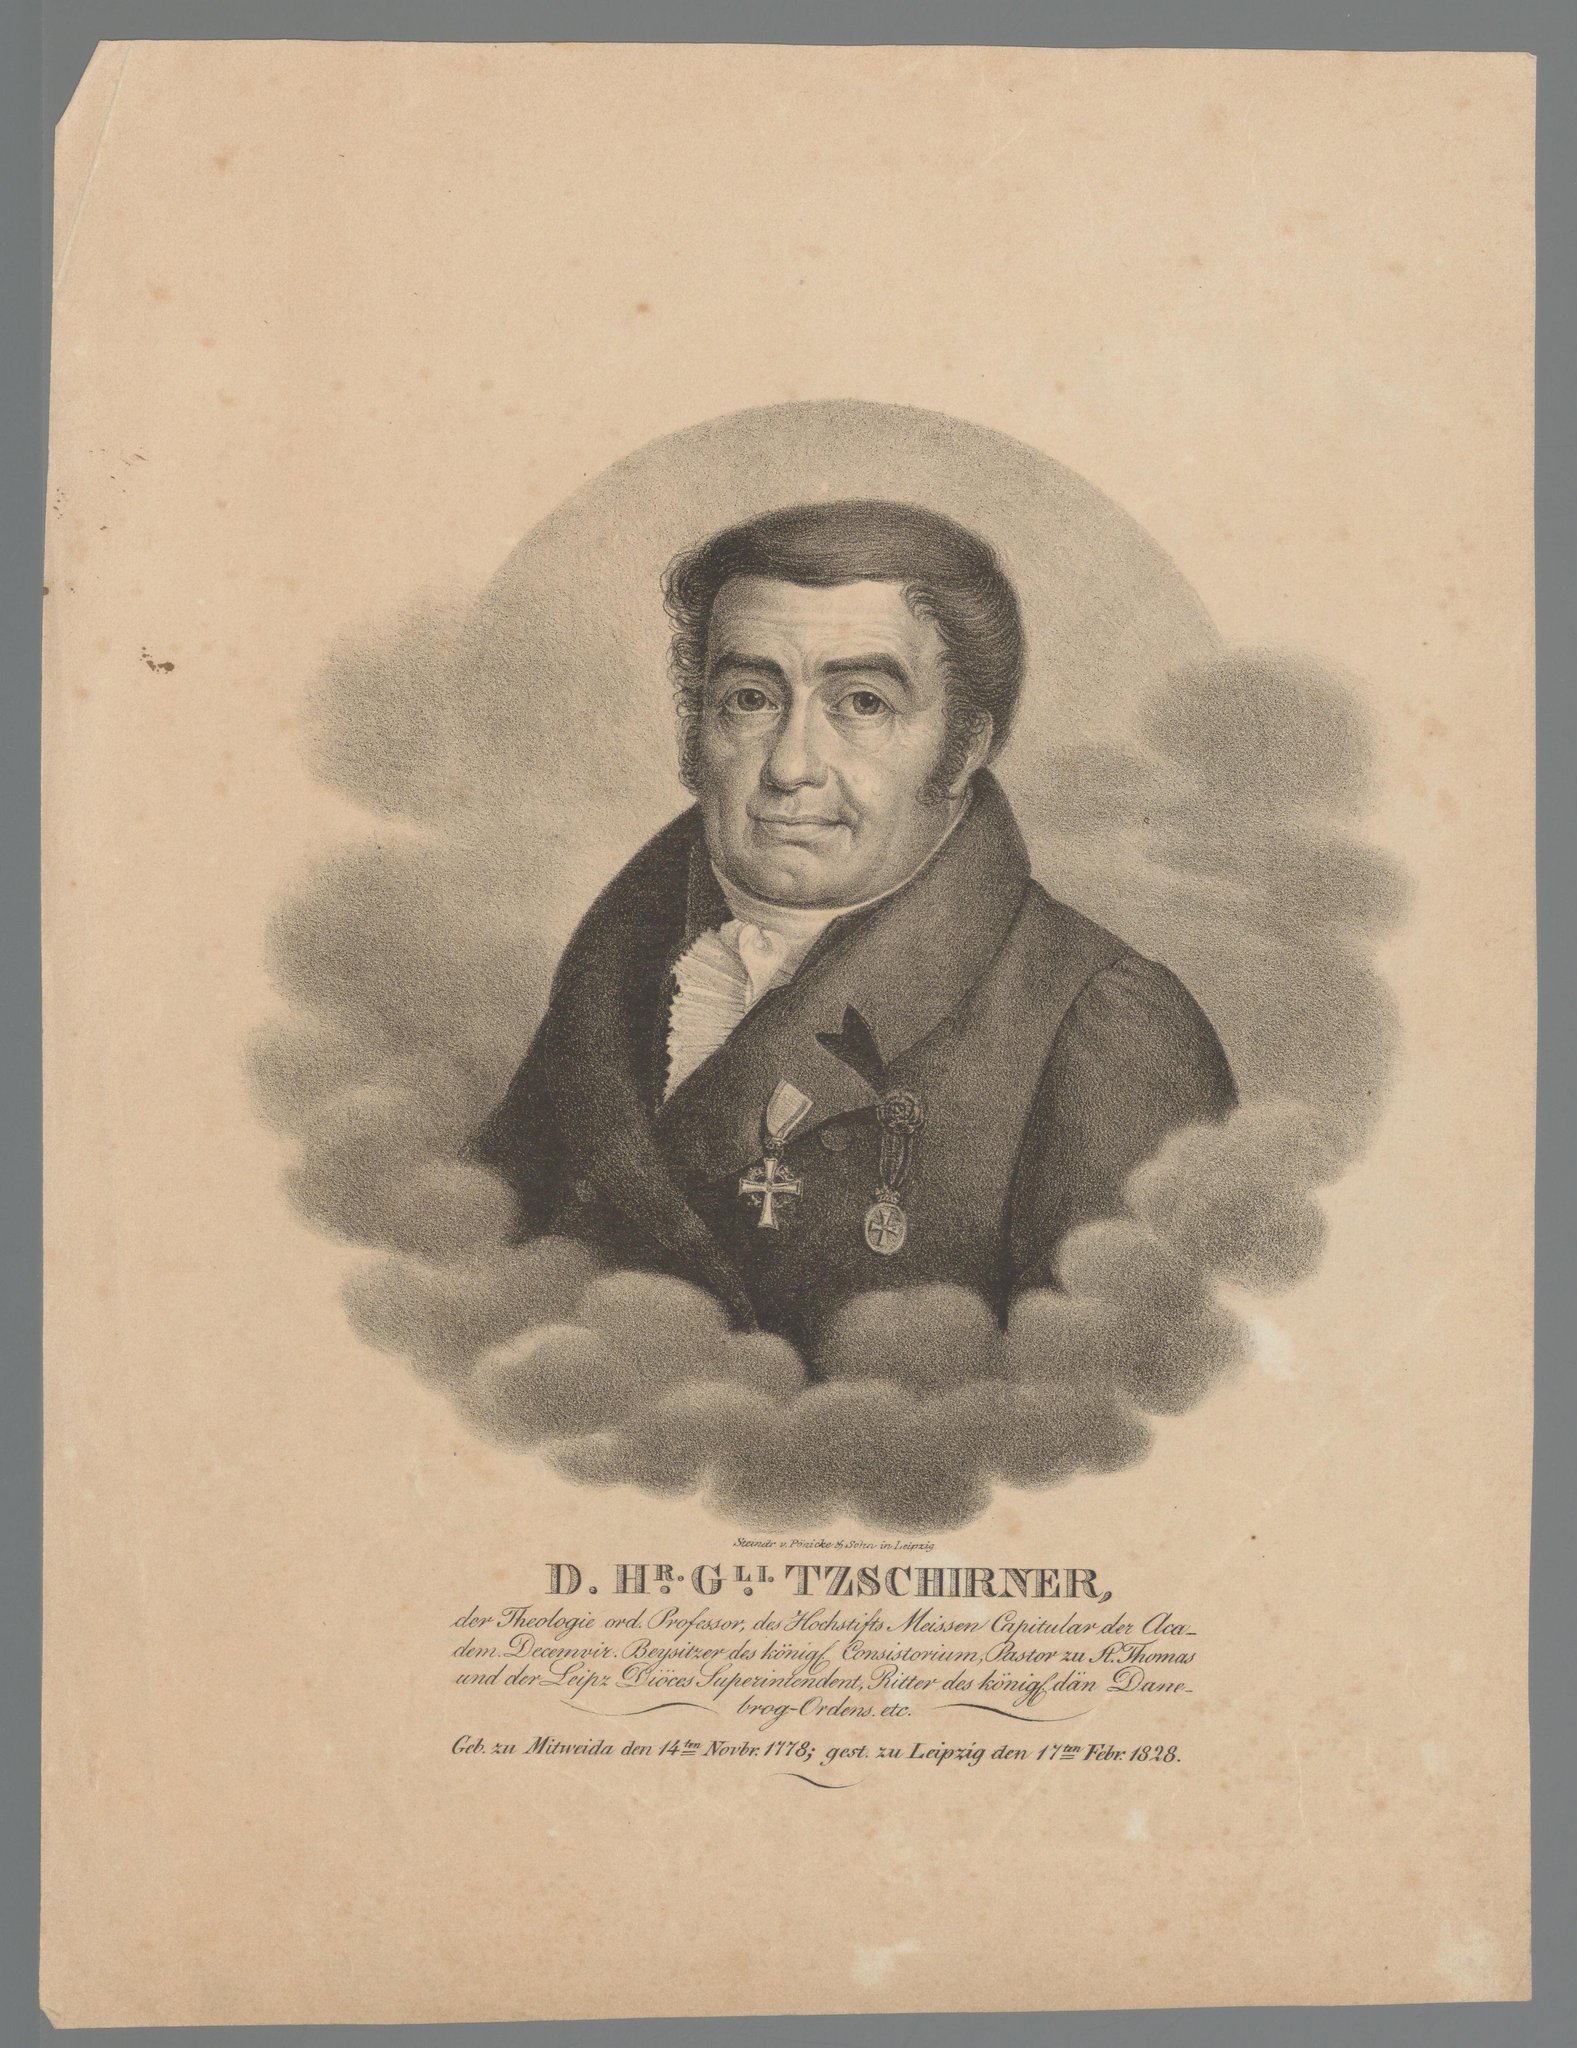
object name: print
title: D.Hr. Gli. Tzschirner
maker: Anonymous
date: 1828-1850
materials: paper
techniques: lithograph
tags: adult man, historical persons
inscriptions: collector's mark: Lugt 2228